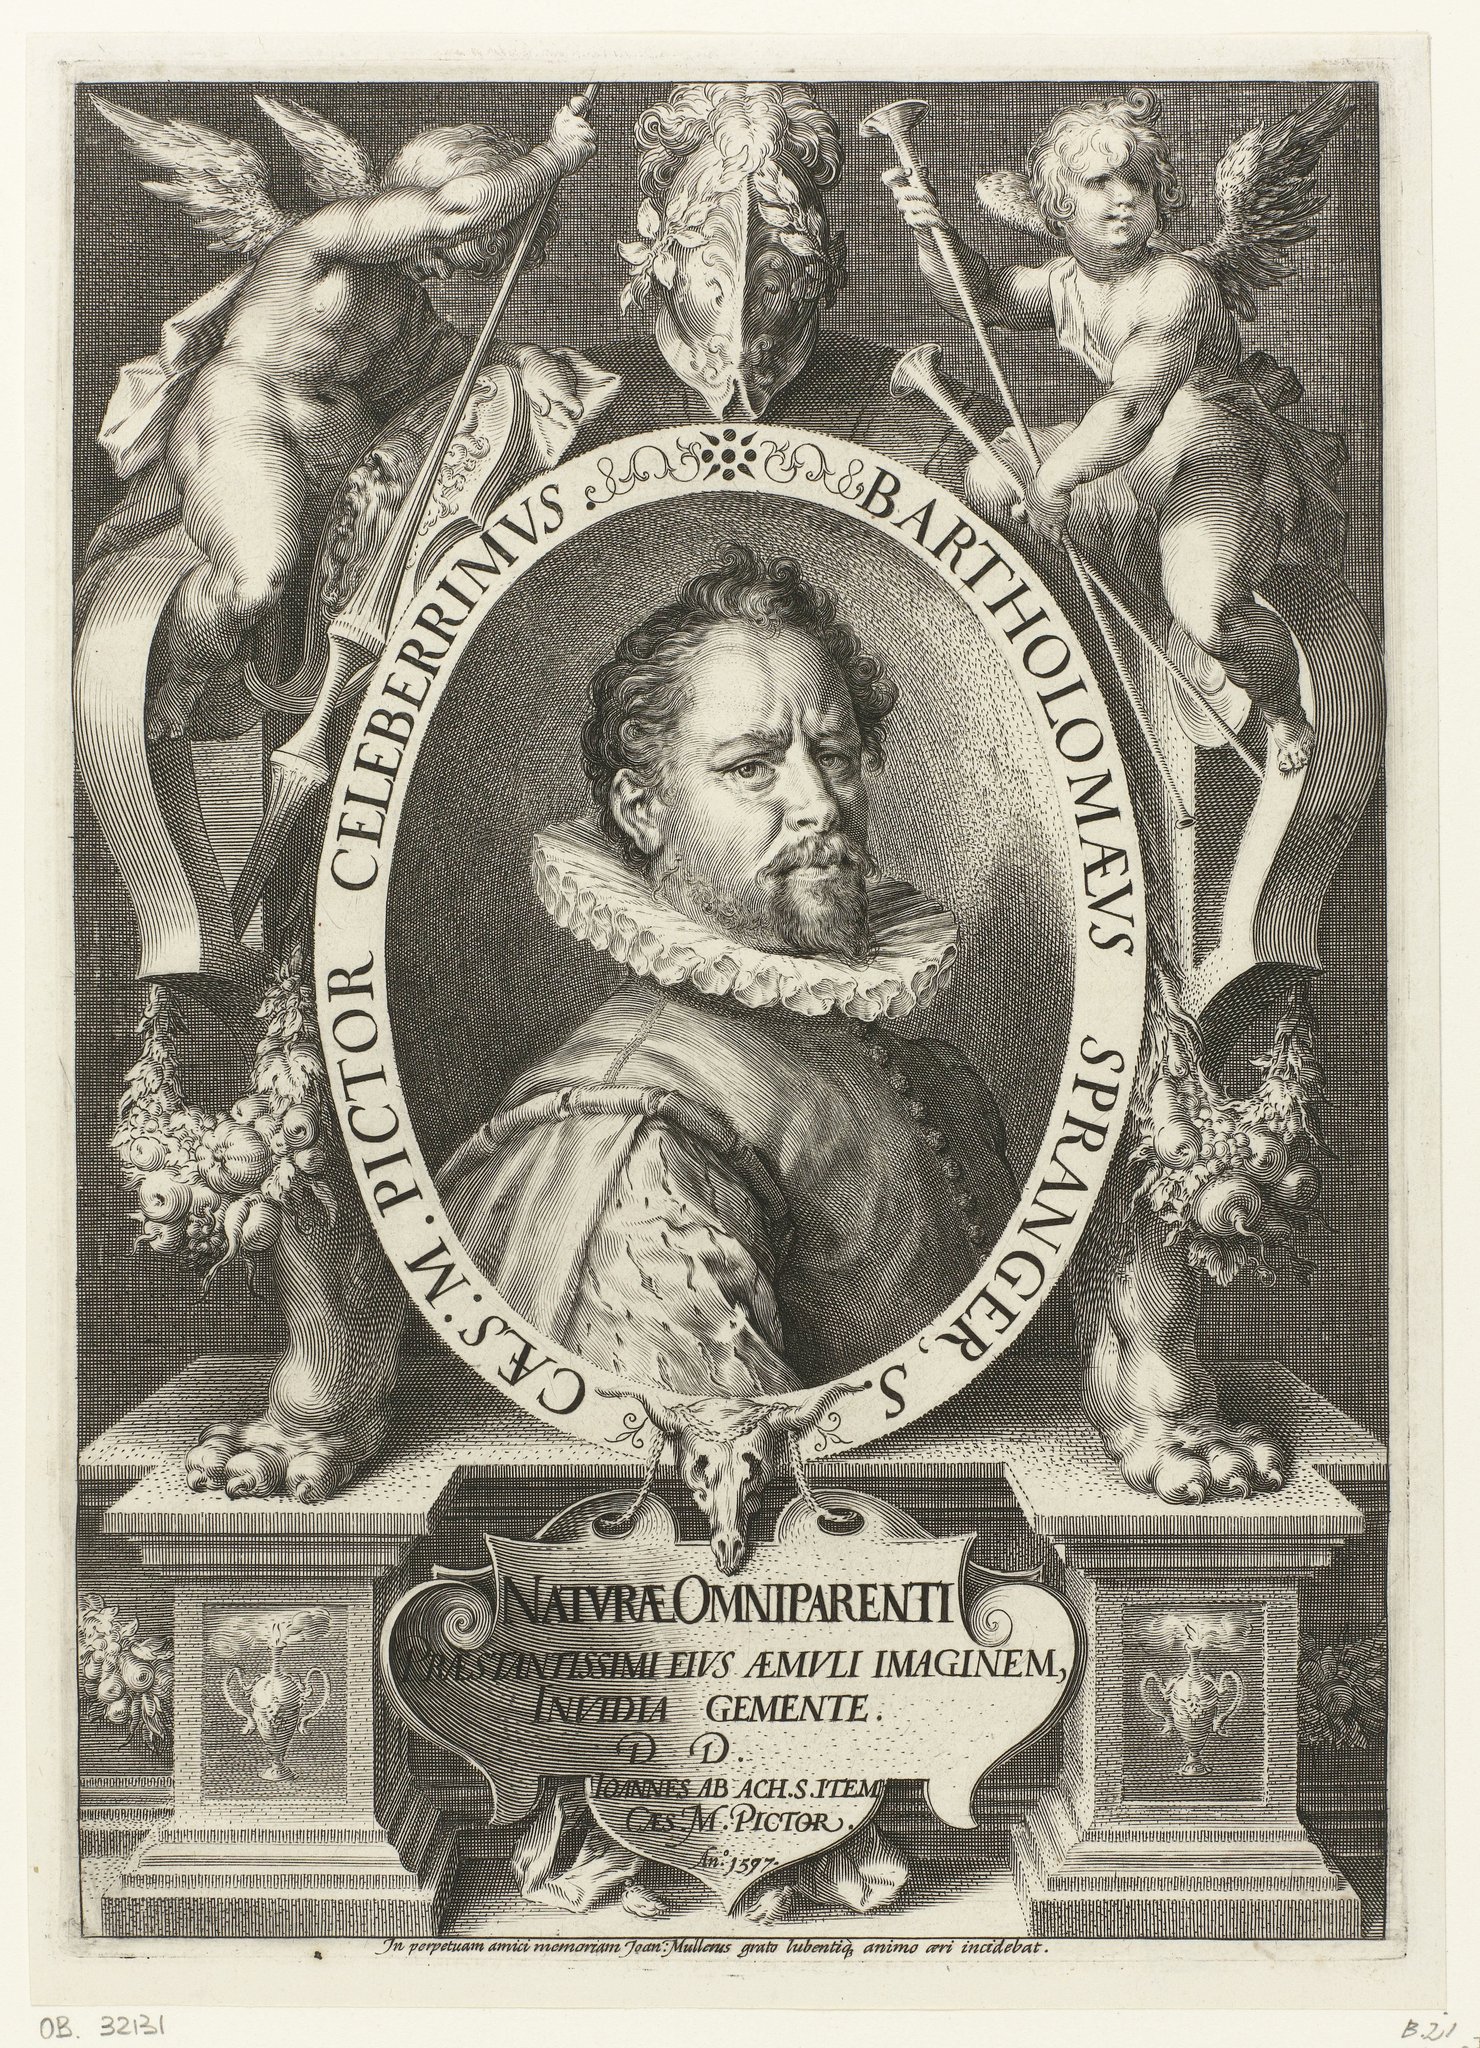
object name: print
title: Portret van Bartholomeus Spranger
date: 1597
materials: paper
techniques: engraving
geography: amsterdam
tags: antwerp, prague, print maker, draughtsman, bartholomeus spranger, portrait, self-portrait of artist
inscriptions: collector's mark: Lugt 240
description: Portret van schilder en prentmaker Bartholomeus Spranger in een ovale lijst met randschrift. Rond de lijst een ornamentele rand bekroond met twee putti.